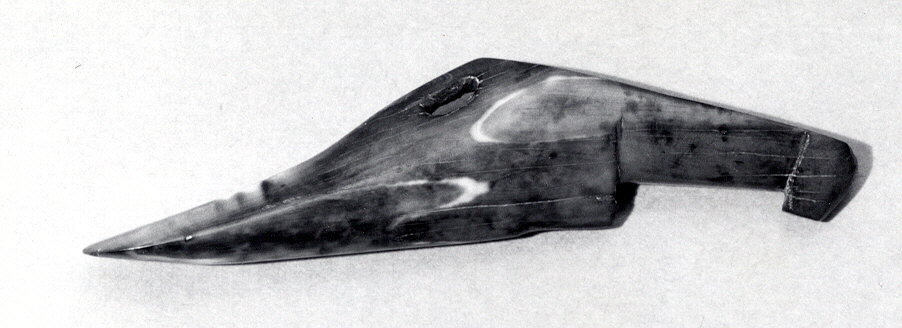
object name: hook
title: Harpoon Head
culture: punuk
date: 1001-1200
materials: ivory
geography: united states